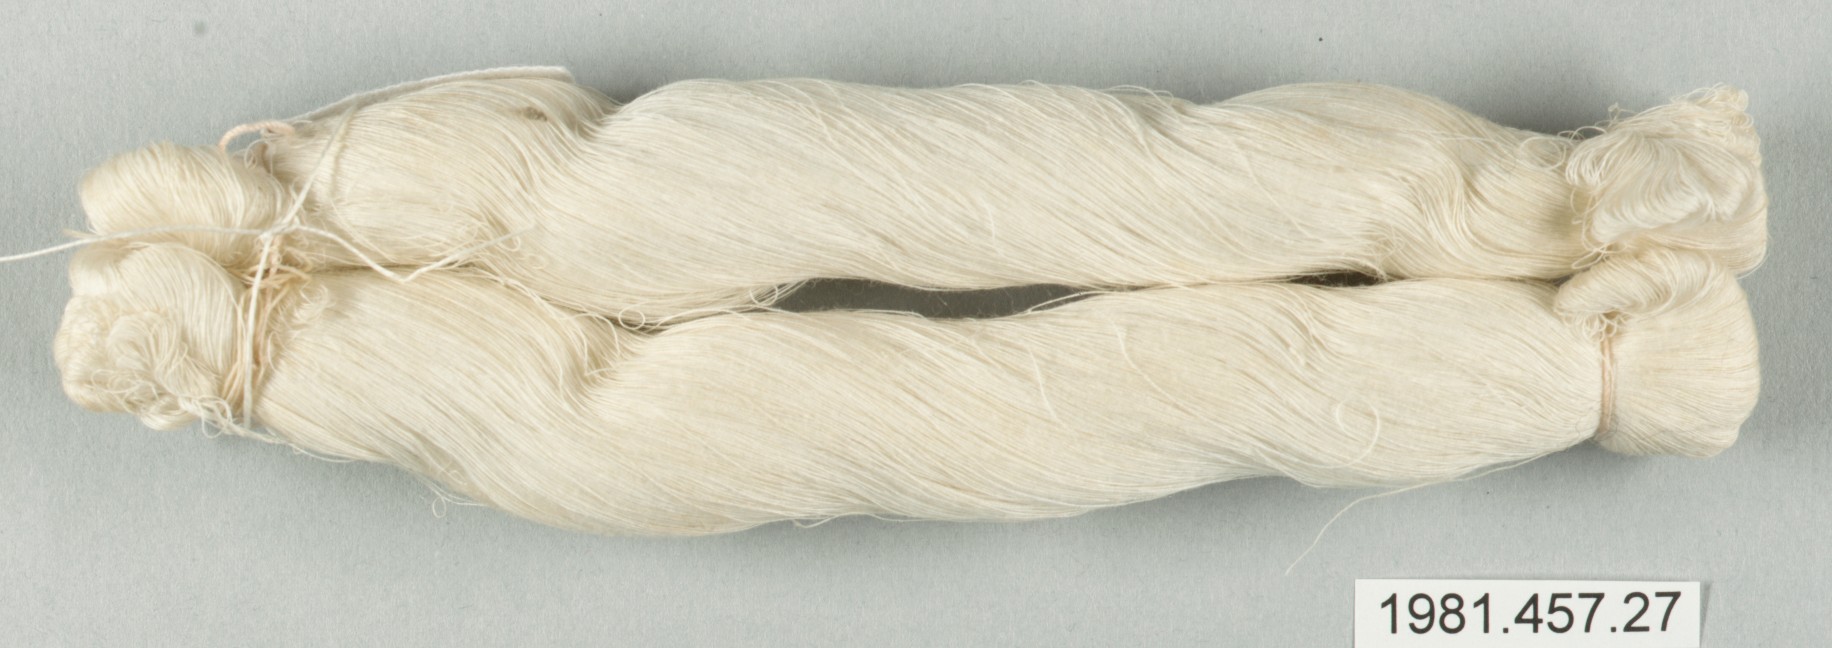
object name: skein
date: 1840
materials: cotton